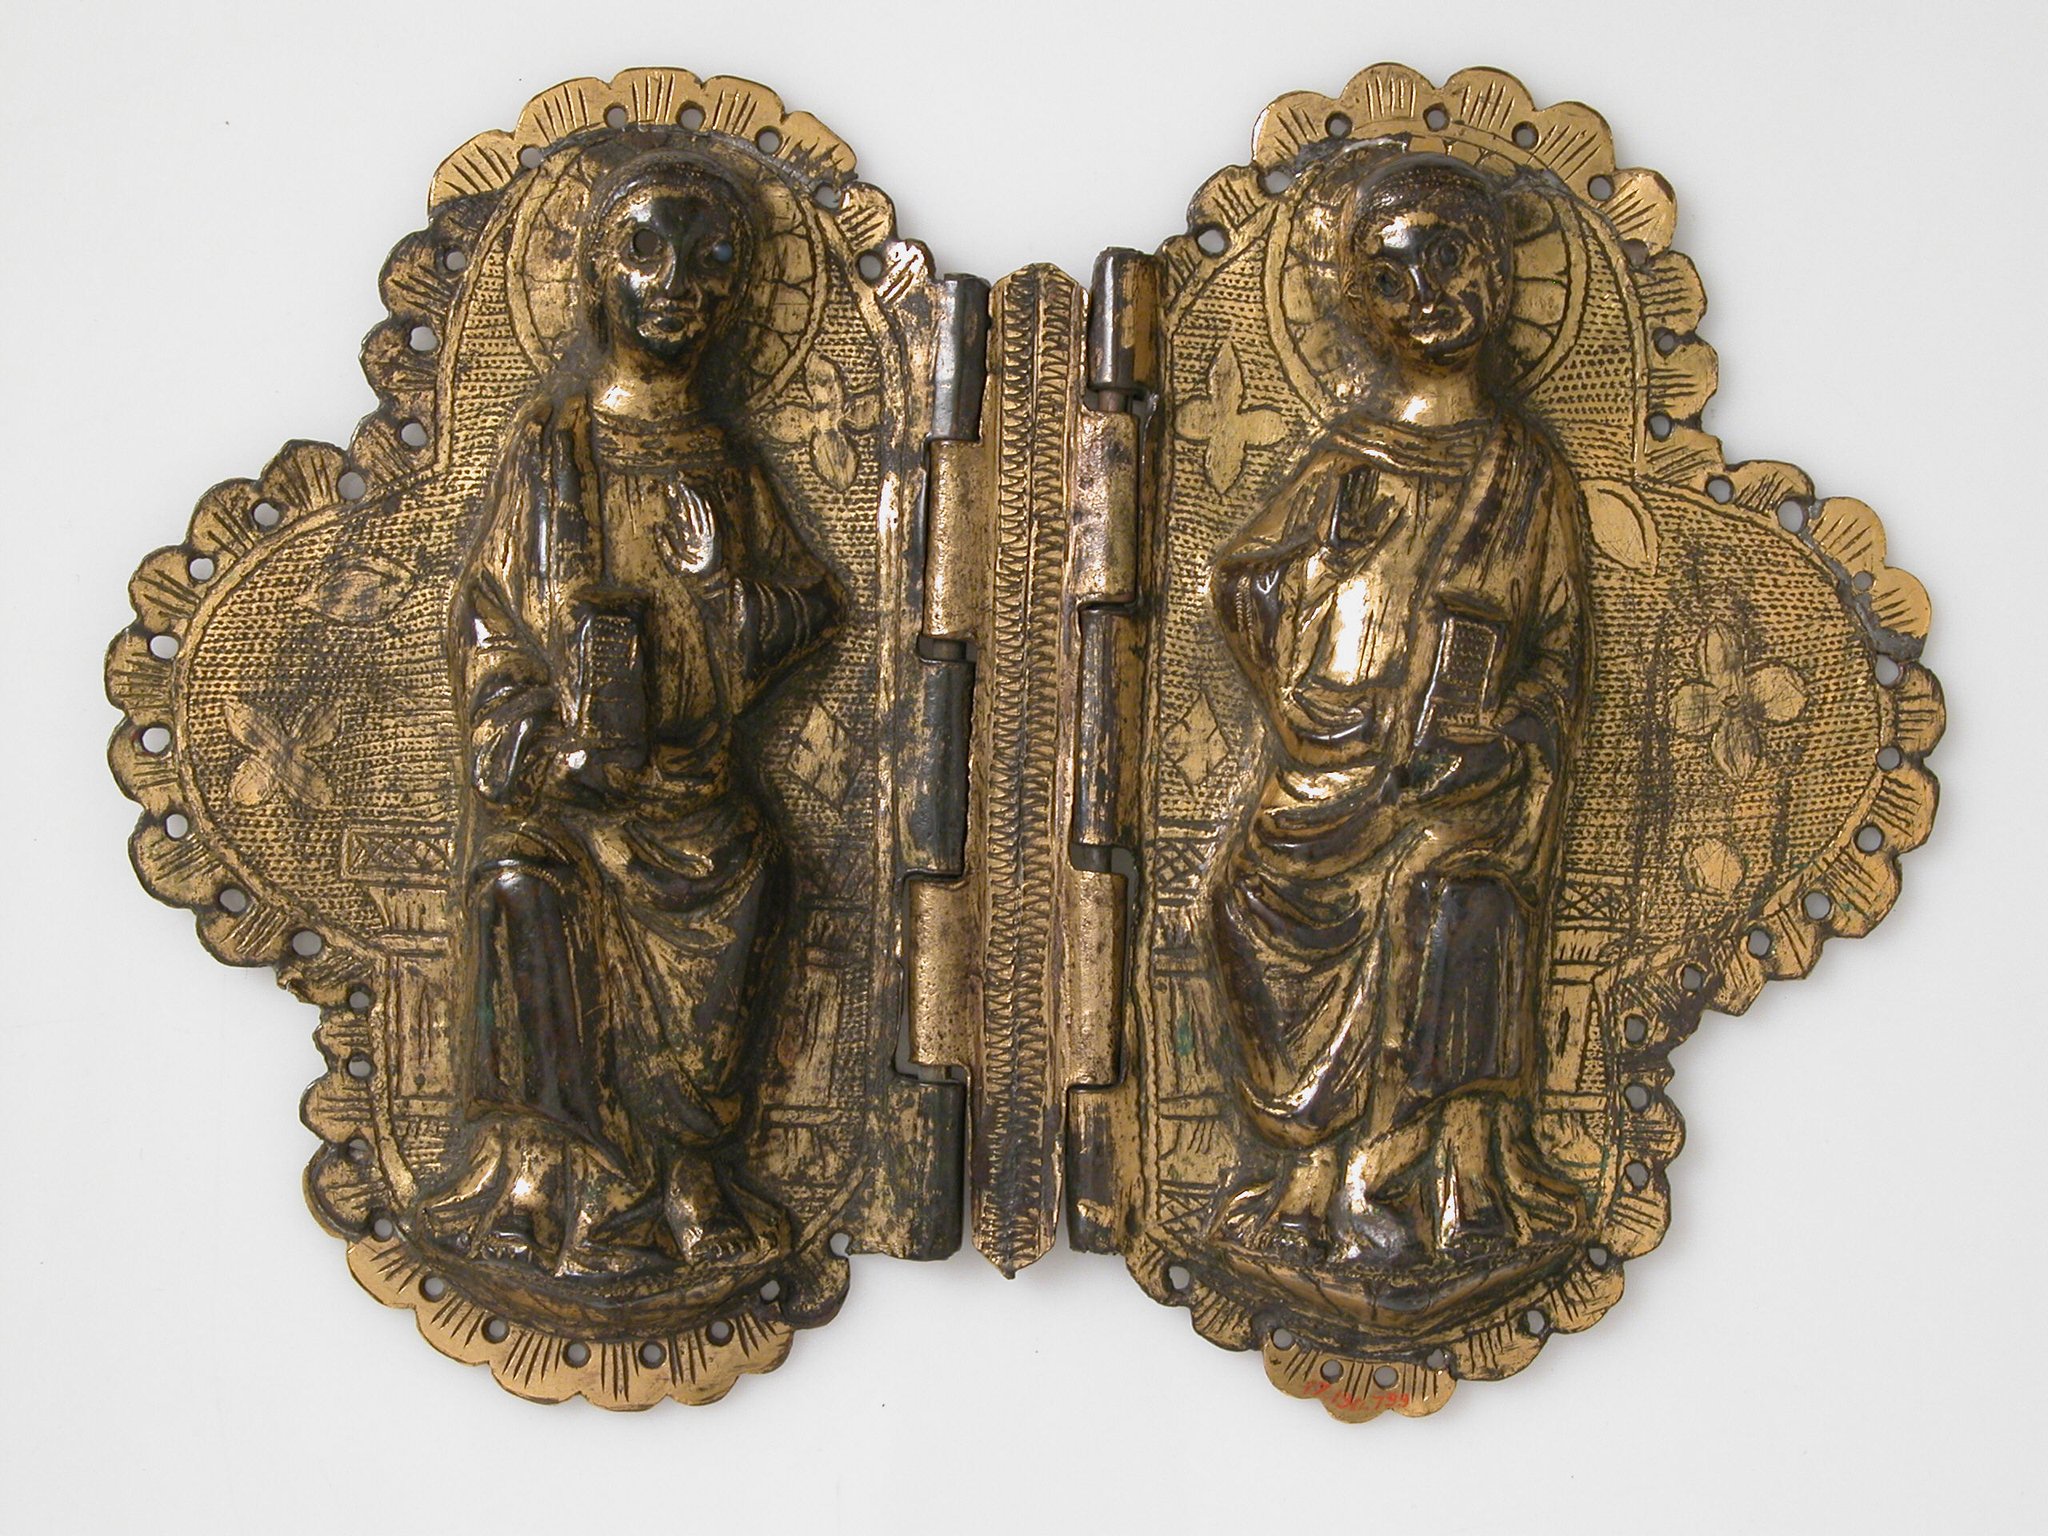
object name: morse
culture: french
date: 1250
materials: gilt copper, glass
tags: human figures